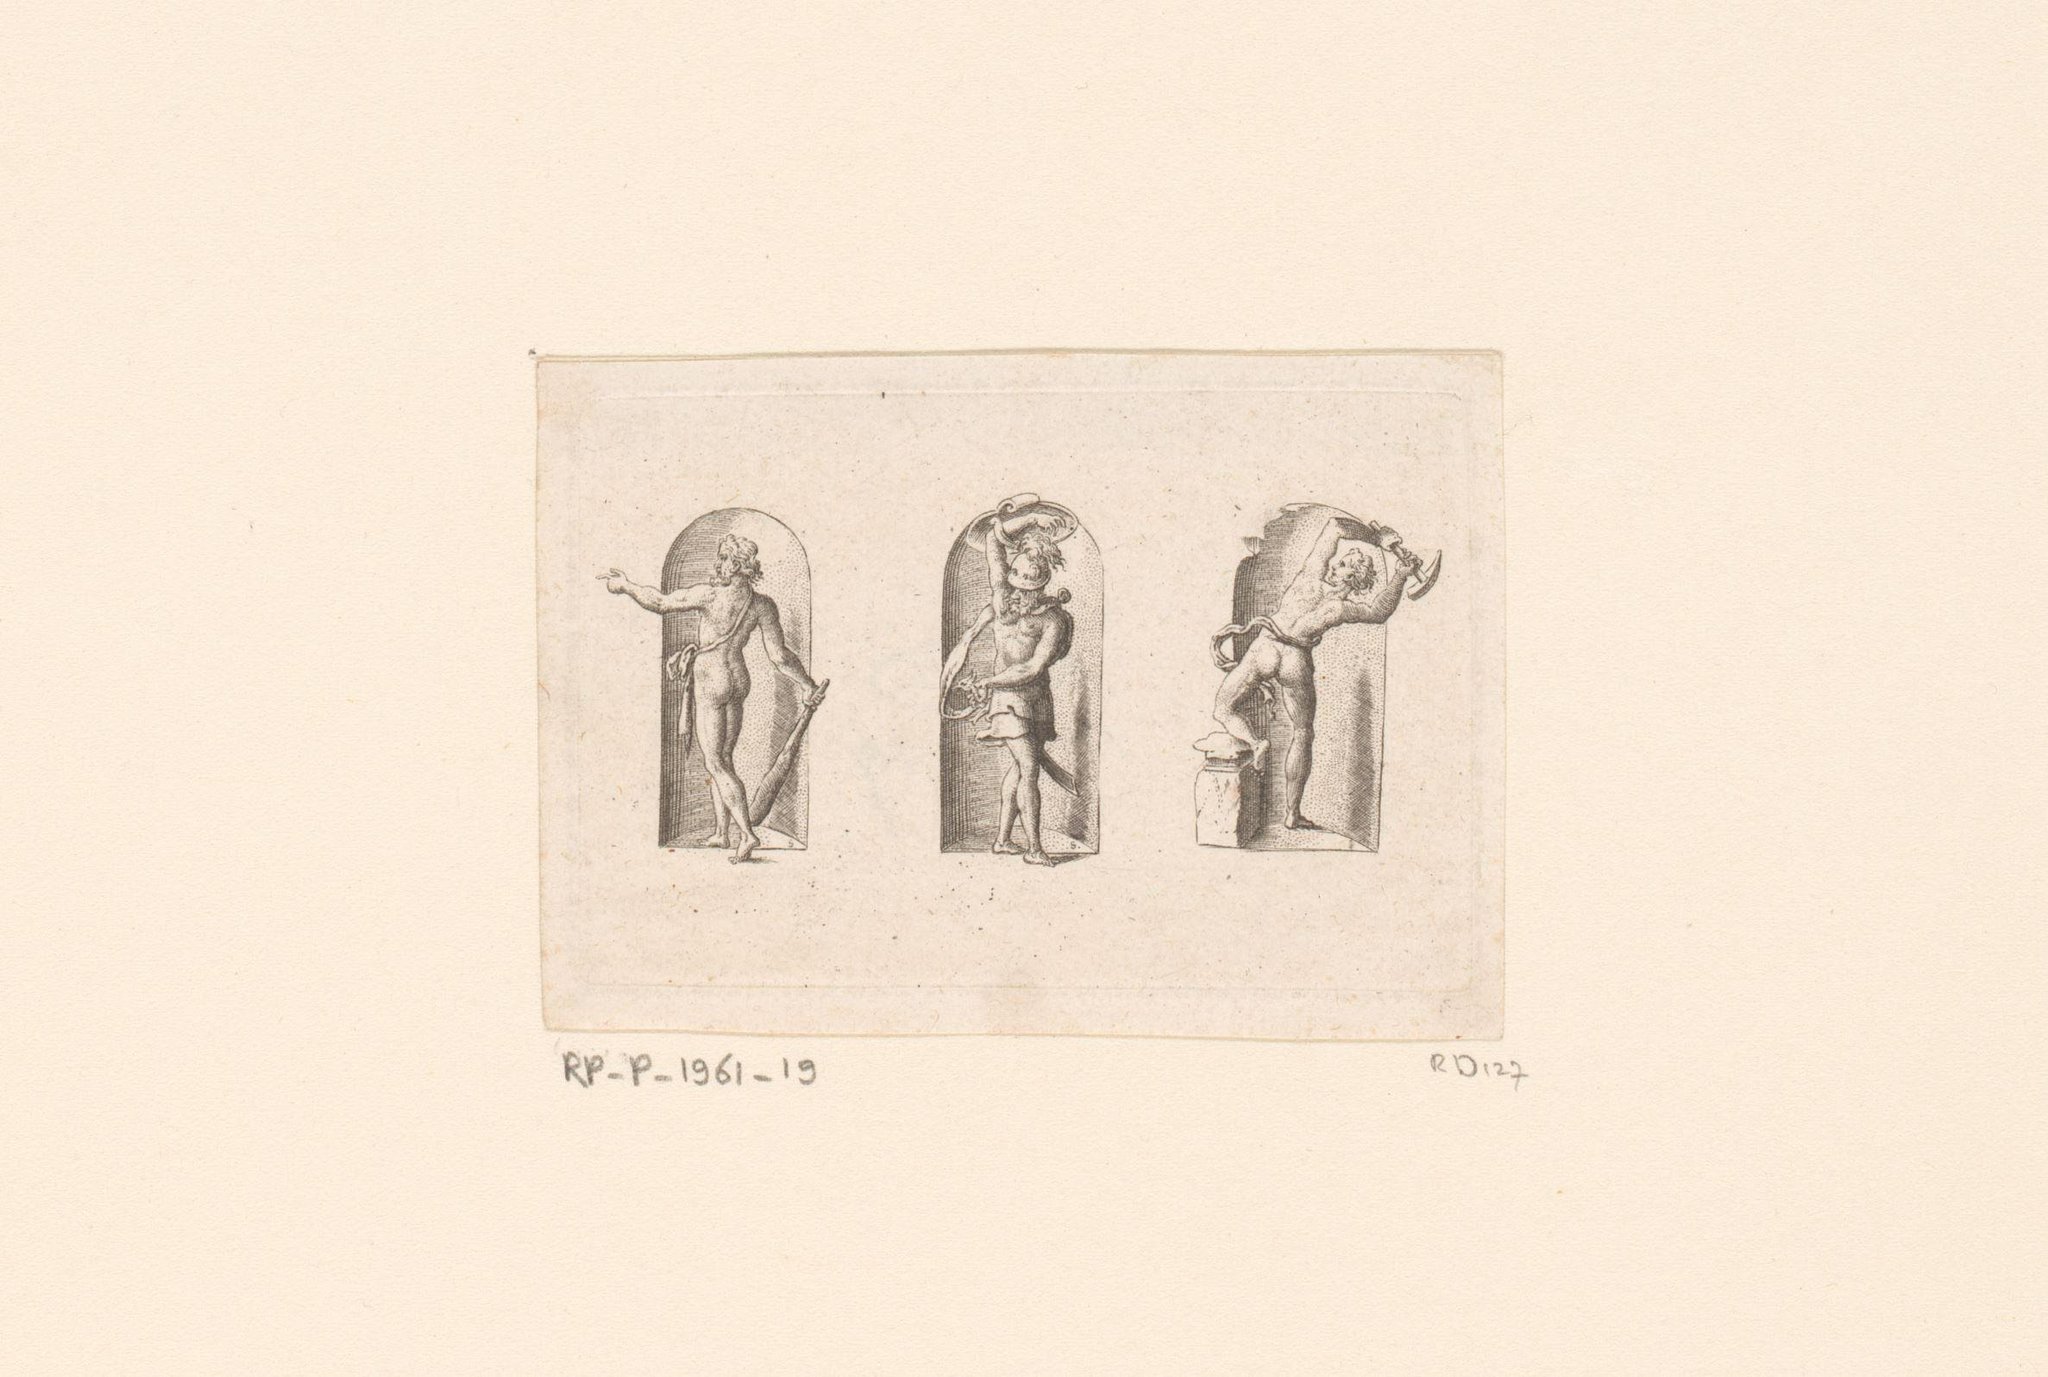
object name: print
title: Divinités de l'Antiquité Païenne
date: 1578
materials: paper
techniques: engraving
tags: (story of) hercules (heracles), (story of) mars (ares), (story of) vulcan (hephaestus)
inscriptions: collector's mark: Lugt 2760, collector's mark: Lugt 2228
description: Maakt deel uit van een zevendelige serie (inclusief titelprent) met op elke prent drie klassieke goden in nissen. Enkel de titelprent vormt een uitzondering. Hier zijn twee in plaats van drie nissen weergegeven, waar de figuren geen goden voorstellen. Waarschijnlijk vervaardigde Delaune deze prenten tijdens zijn verblijf in Duitsland (Pollet, p. 693).